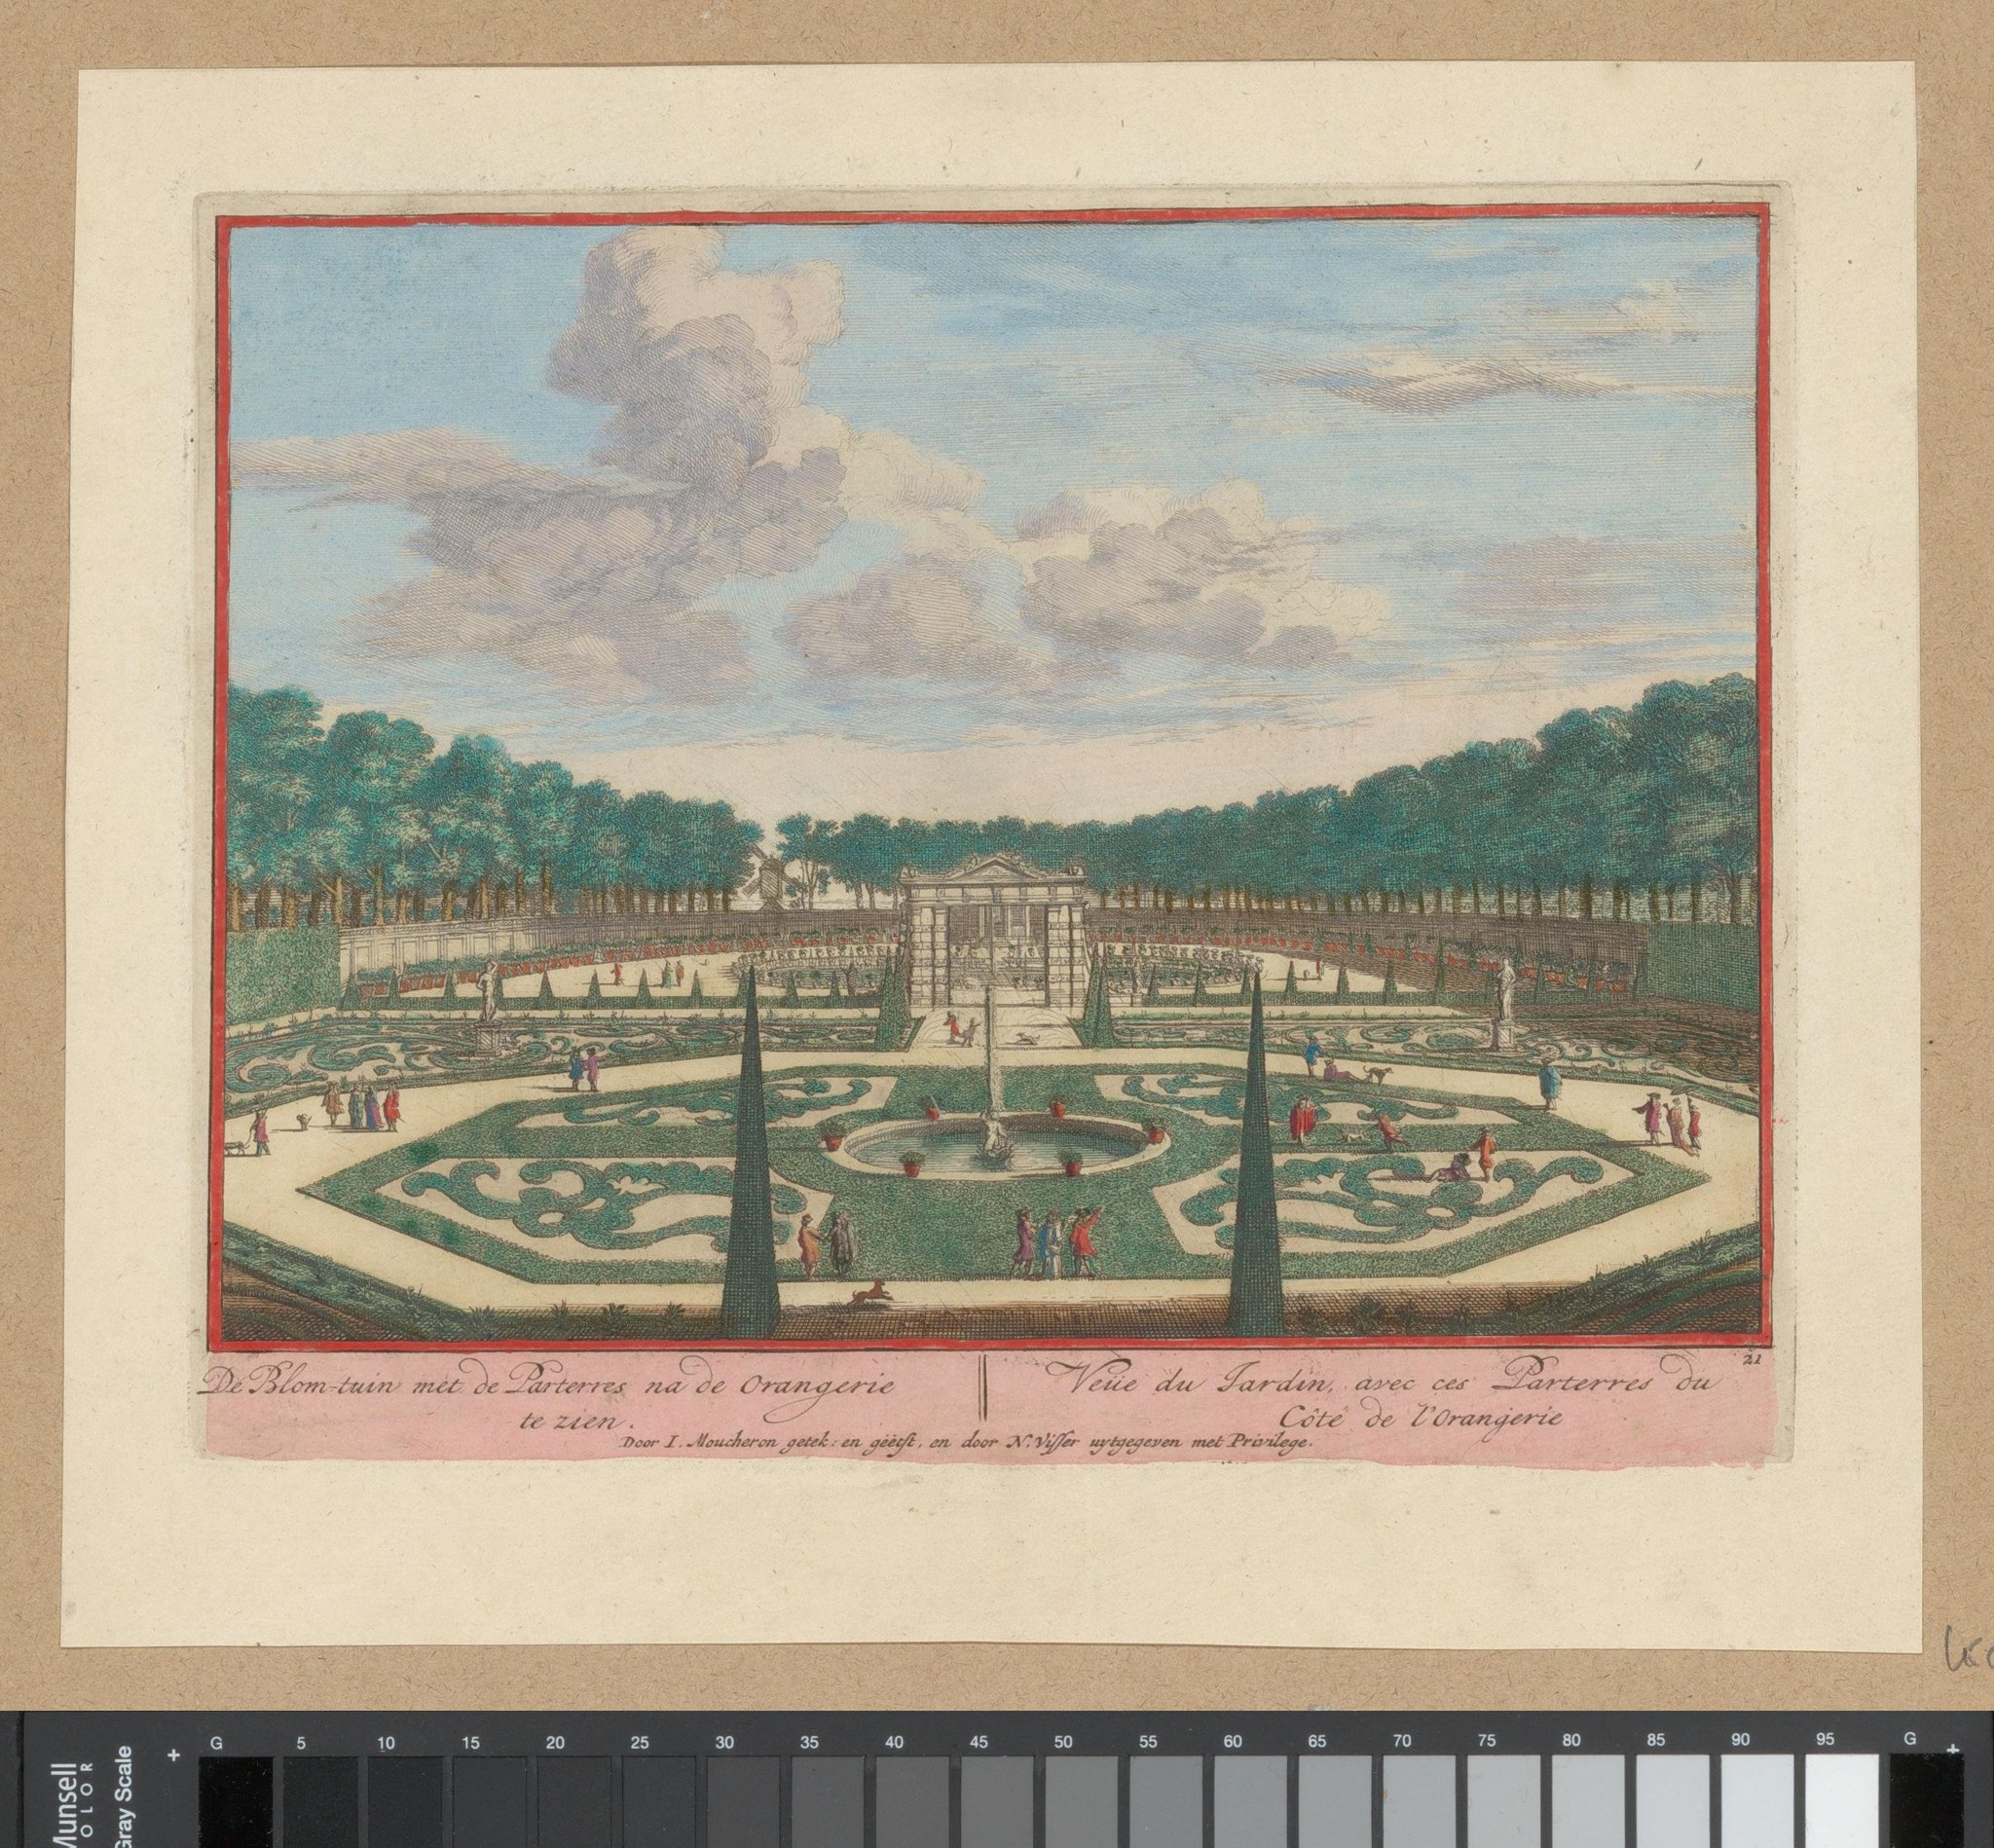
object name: print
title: Gezichten op Kasteel Heemstede in de provincie Utrecht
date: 1706-1719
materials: paper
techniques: engraving, etching, hand coloring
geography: amsterdam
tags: french or architectonic garden; formal garden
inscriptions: stamp, collector's mark: Lugt 1641, stamp, stamp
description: De bloementuin met parterres en in het midden een fontein bij Kasteel Heemstede. Rechtsonder genummerd: 21. Onderwerpsrubrieken binnen de Atlas Zeden en Gewoonten: Zeden en Gewoonten in Engeren Zin, De Woning, Oude Nederlandsche Tuinkunst, De 17de en 18de eeuw. Stadtuinen.